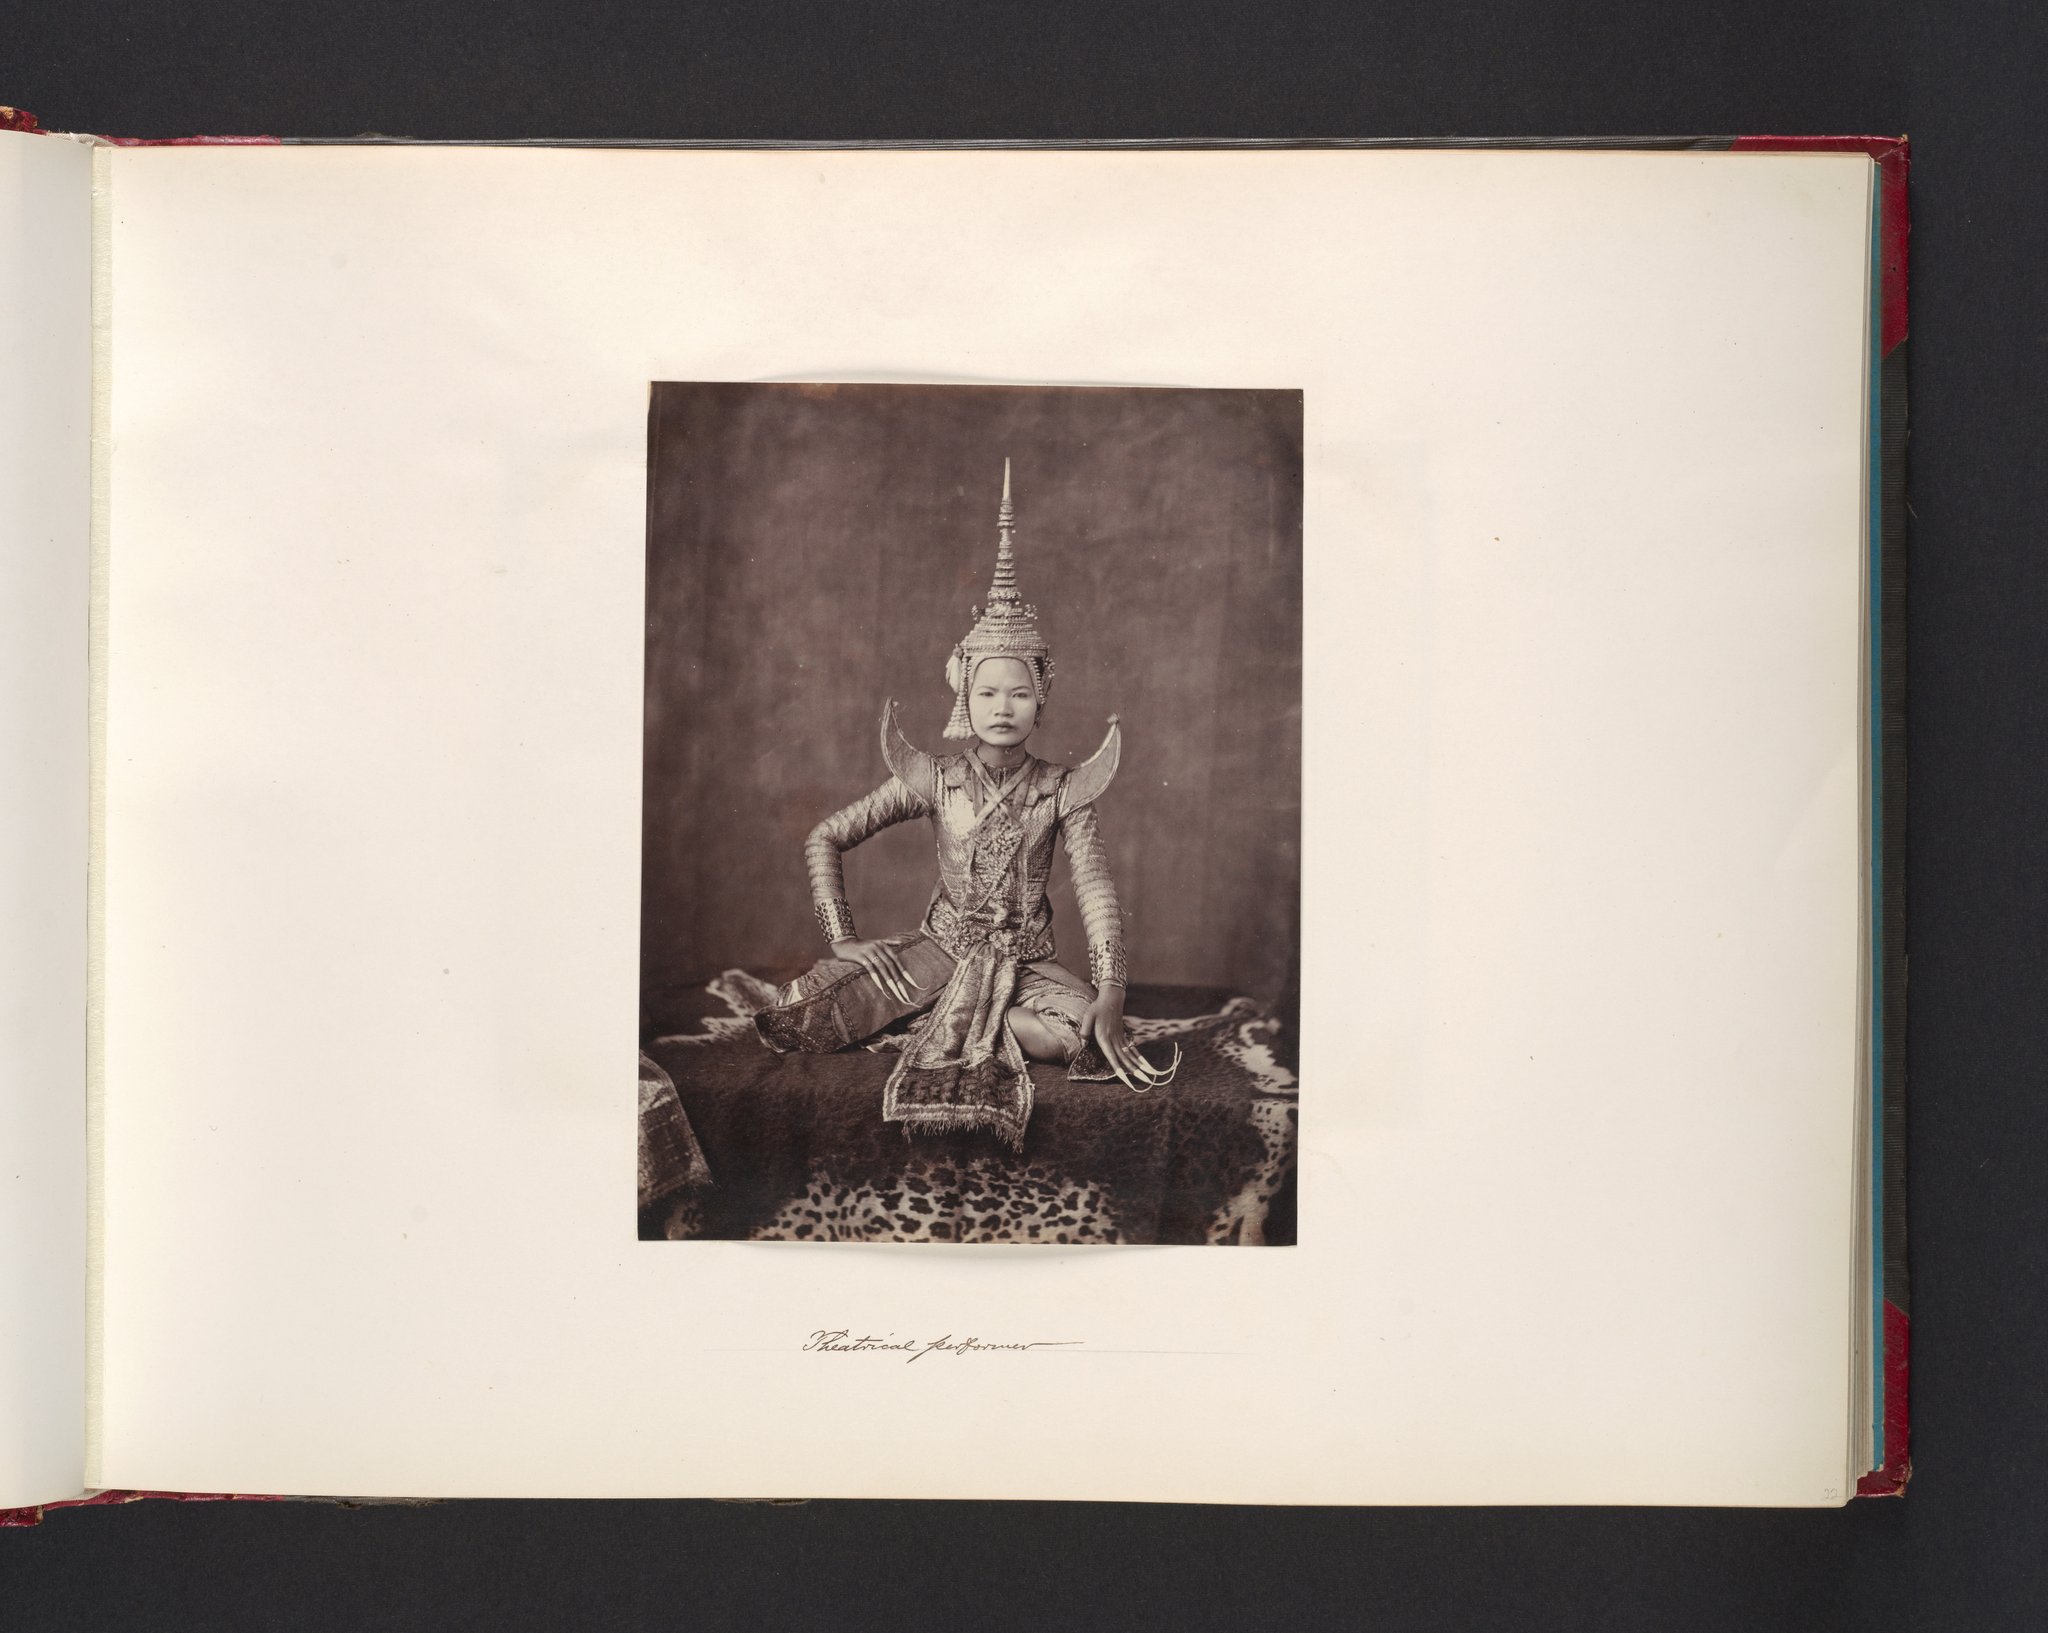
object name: photograph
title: Theatrical Performer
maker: john thomson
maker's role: artist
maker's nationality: british, scottish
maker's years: 1837-1921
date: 1865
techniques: albumen silver print, glass negative